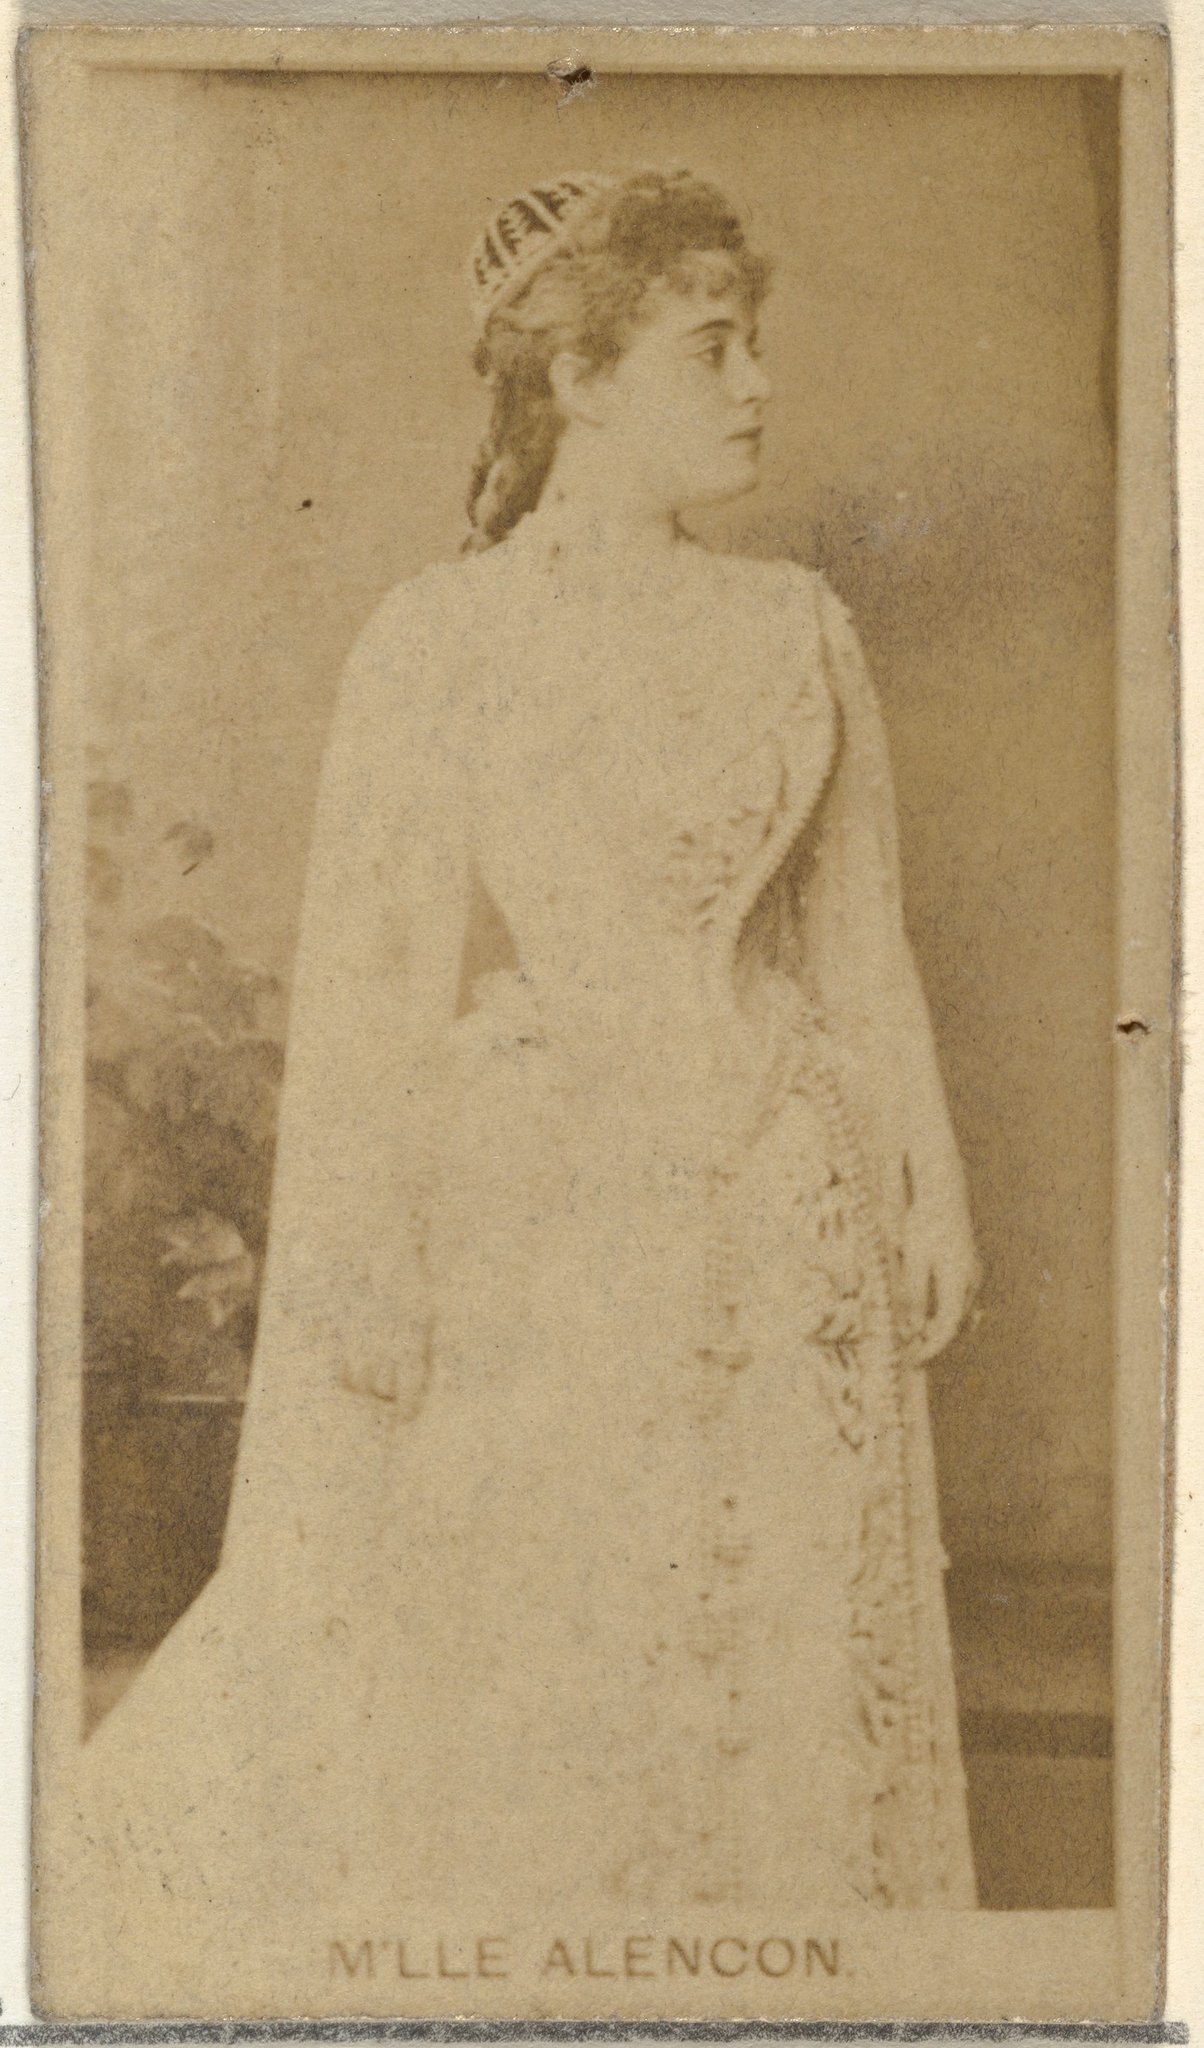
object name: photograph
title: M'lle Alencon, from the Actors and Actresses series (N145-8) issued by Duke Sons & Co. to promote Duke Cigarettes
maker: w. duke, sons & co.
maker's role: publisher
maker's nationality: american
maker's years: 1870-1920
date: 1891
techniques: albumen silver print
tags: portraits,women,actresses